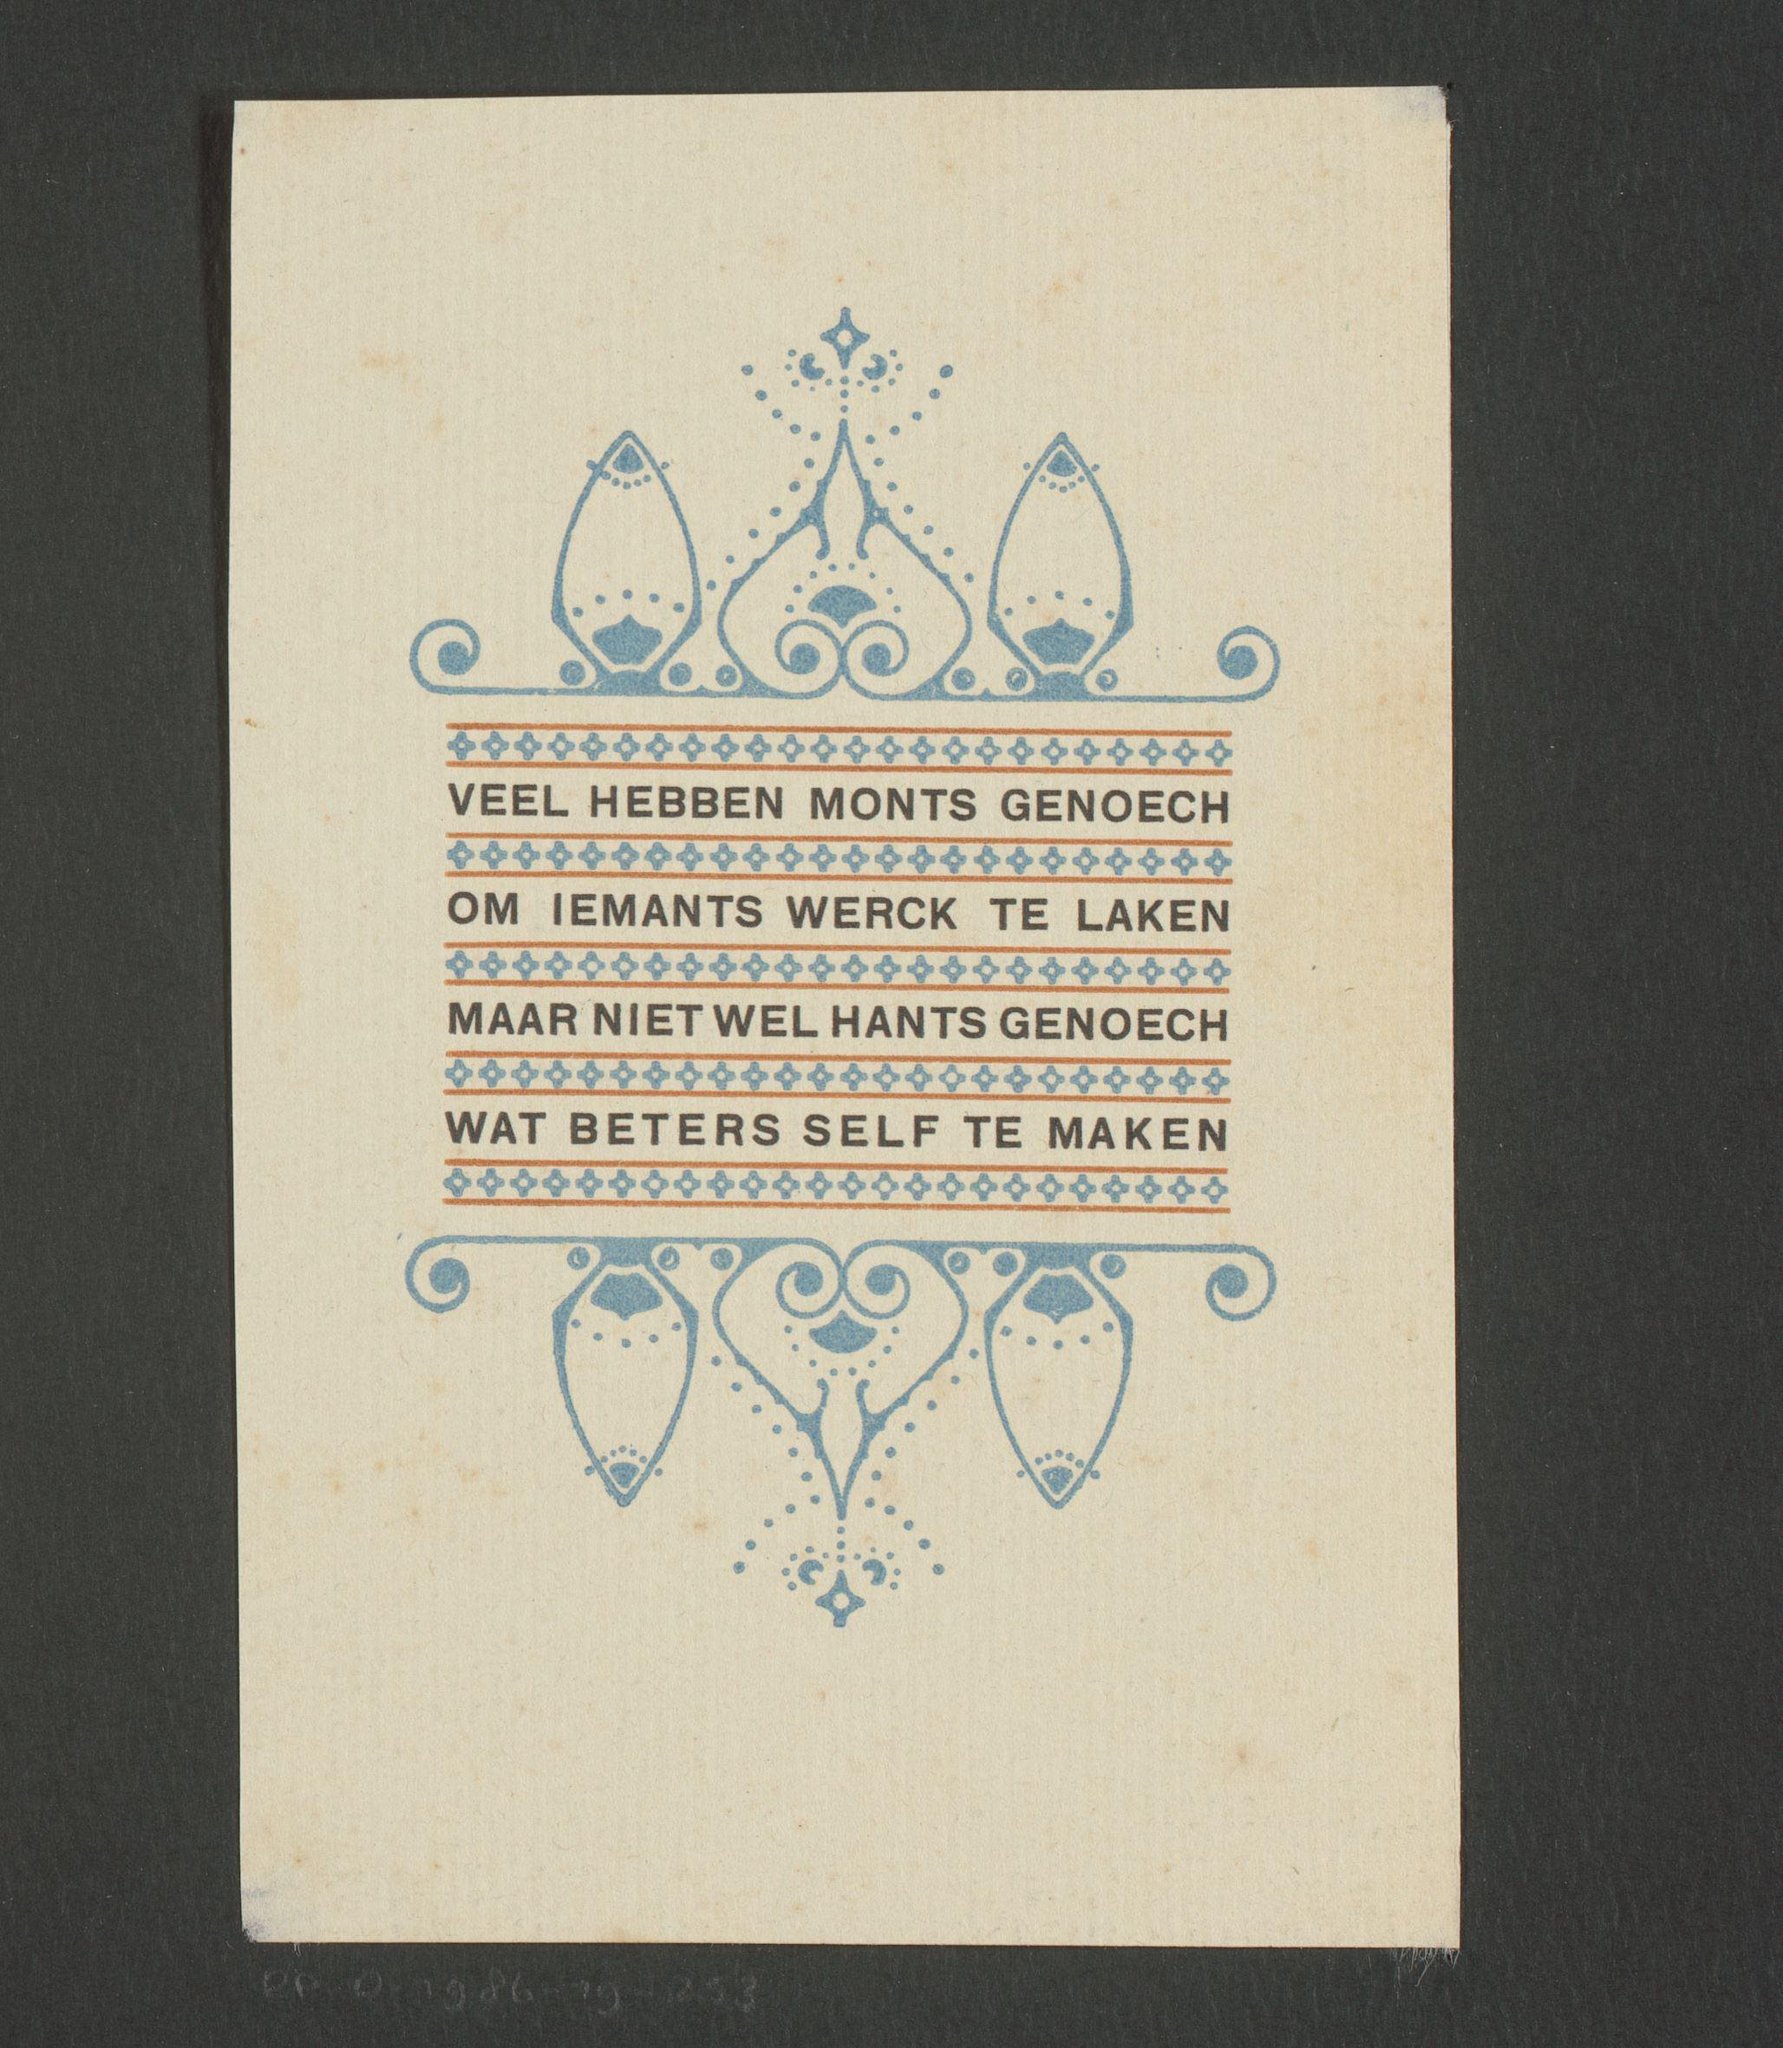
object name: print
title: Veel hebben monts genoech om iemants werk te laken maar niet wel hants genoech wat beters self te maken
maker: reinier willem petrus de vries (1874-1953)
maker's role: draughtsman, print maker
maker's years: 1874-1953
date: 1884-1952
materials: paper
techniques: relief print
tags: ornaments ~ art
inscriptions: collector's mark: ‘R:MVS.’